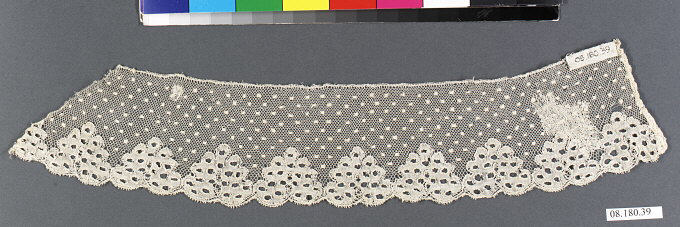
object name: piece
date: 1801-1900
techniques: lace